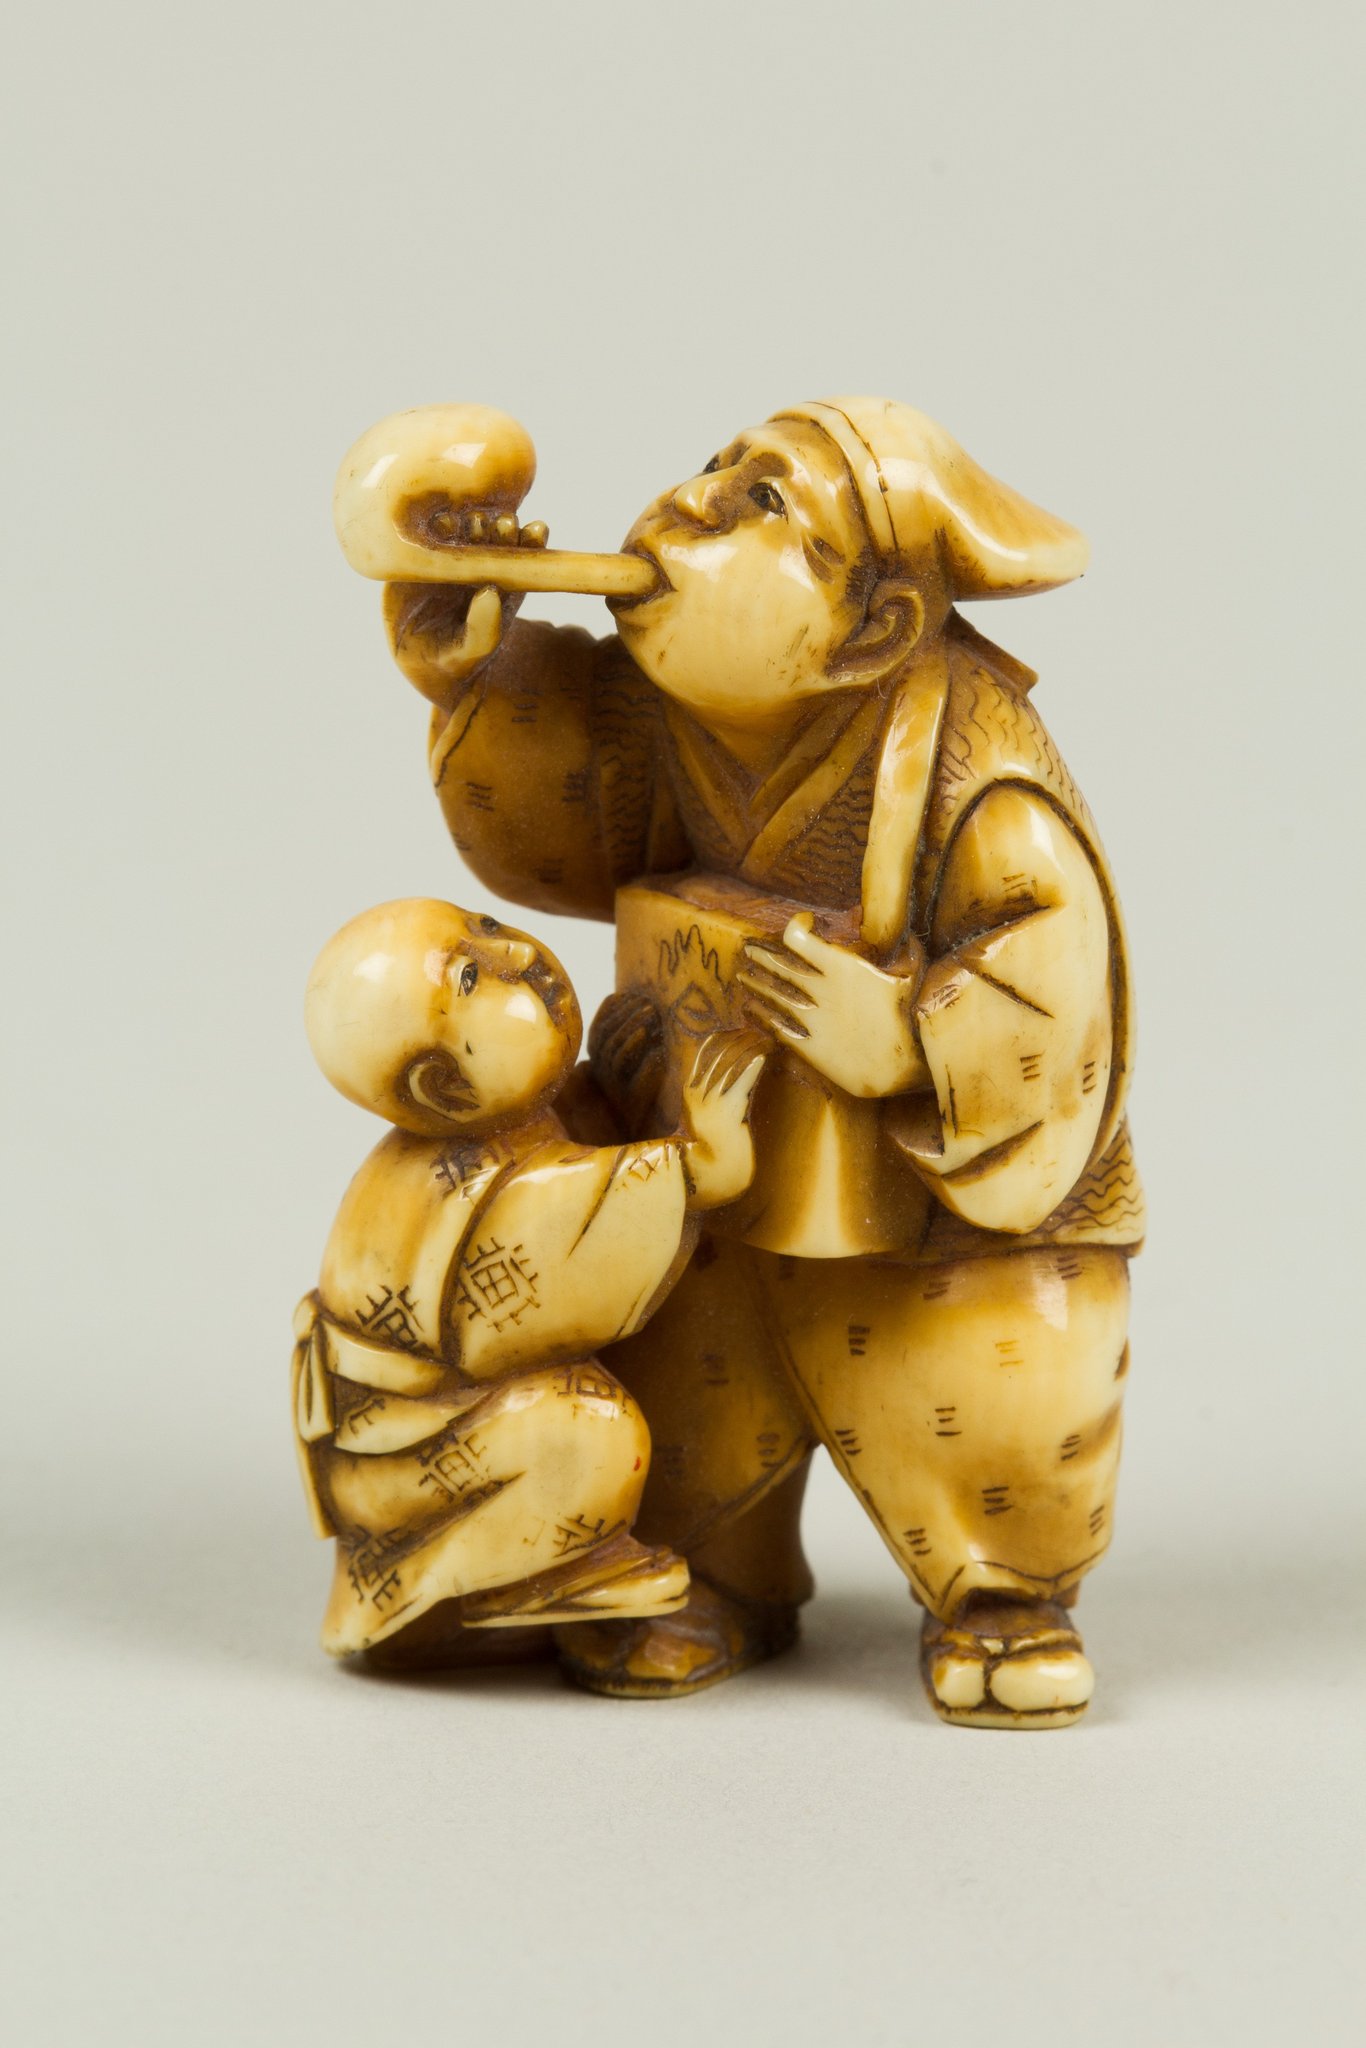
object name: netsuke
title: Netsuke of Man and Child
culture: japanese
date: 1701-1800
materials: ivory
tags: boys,men